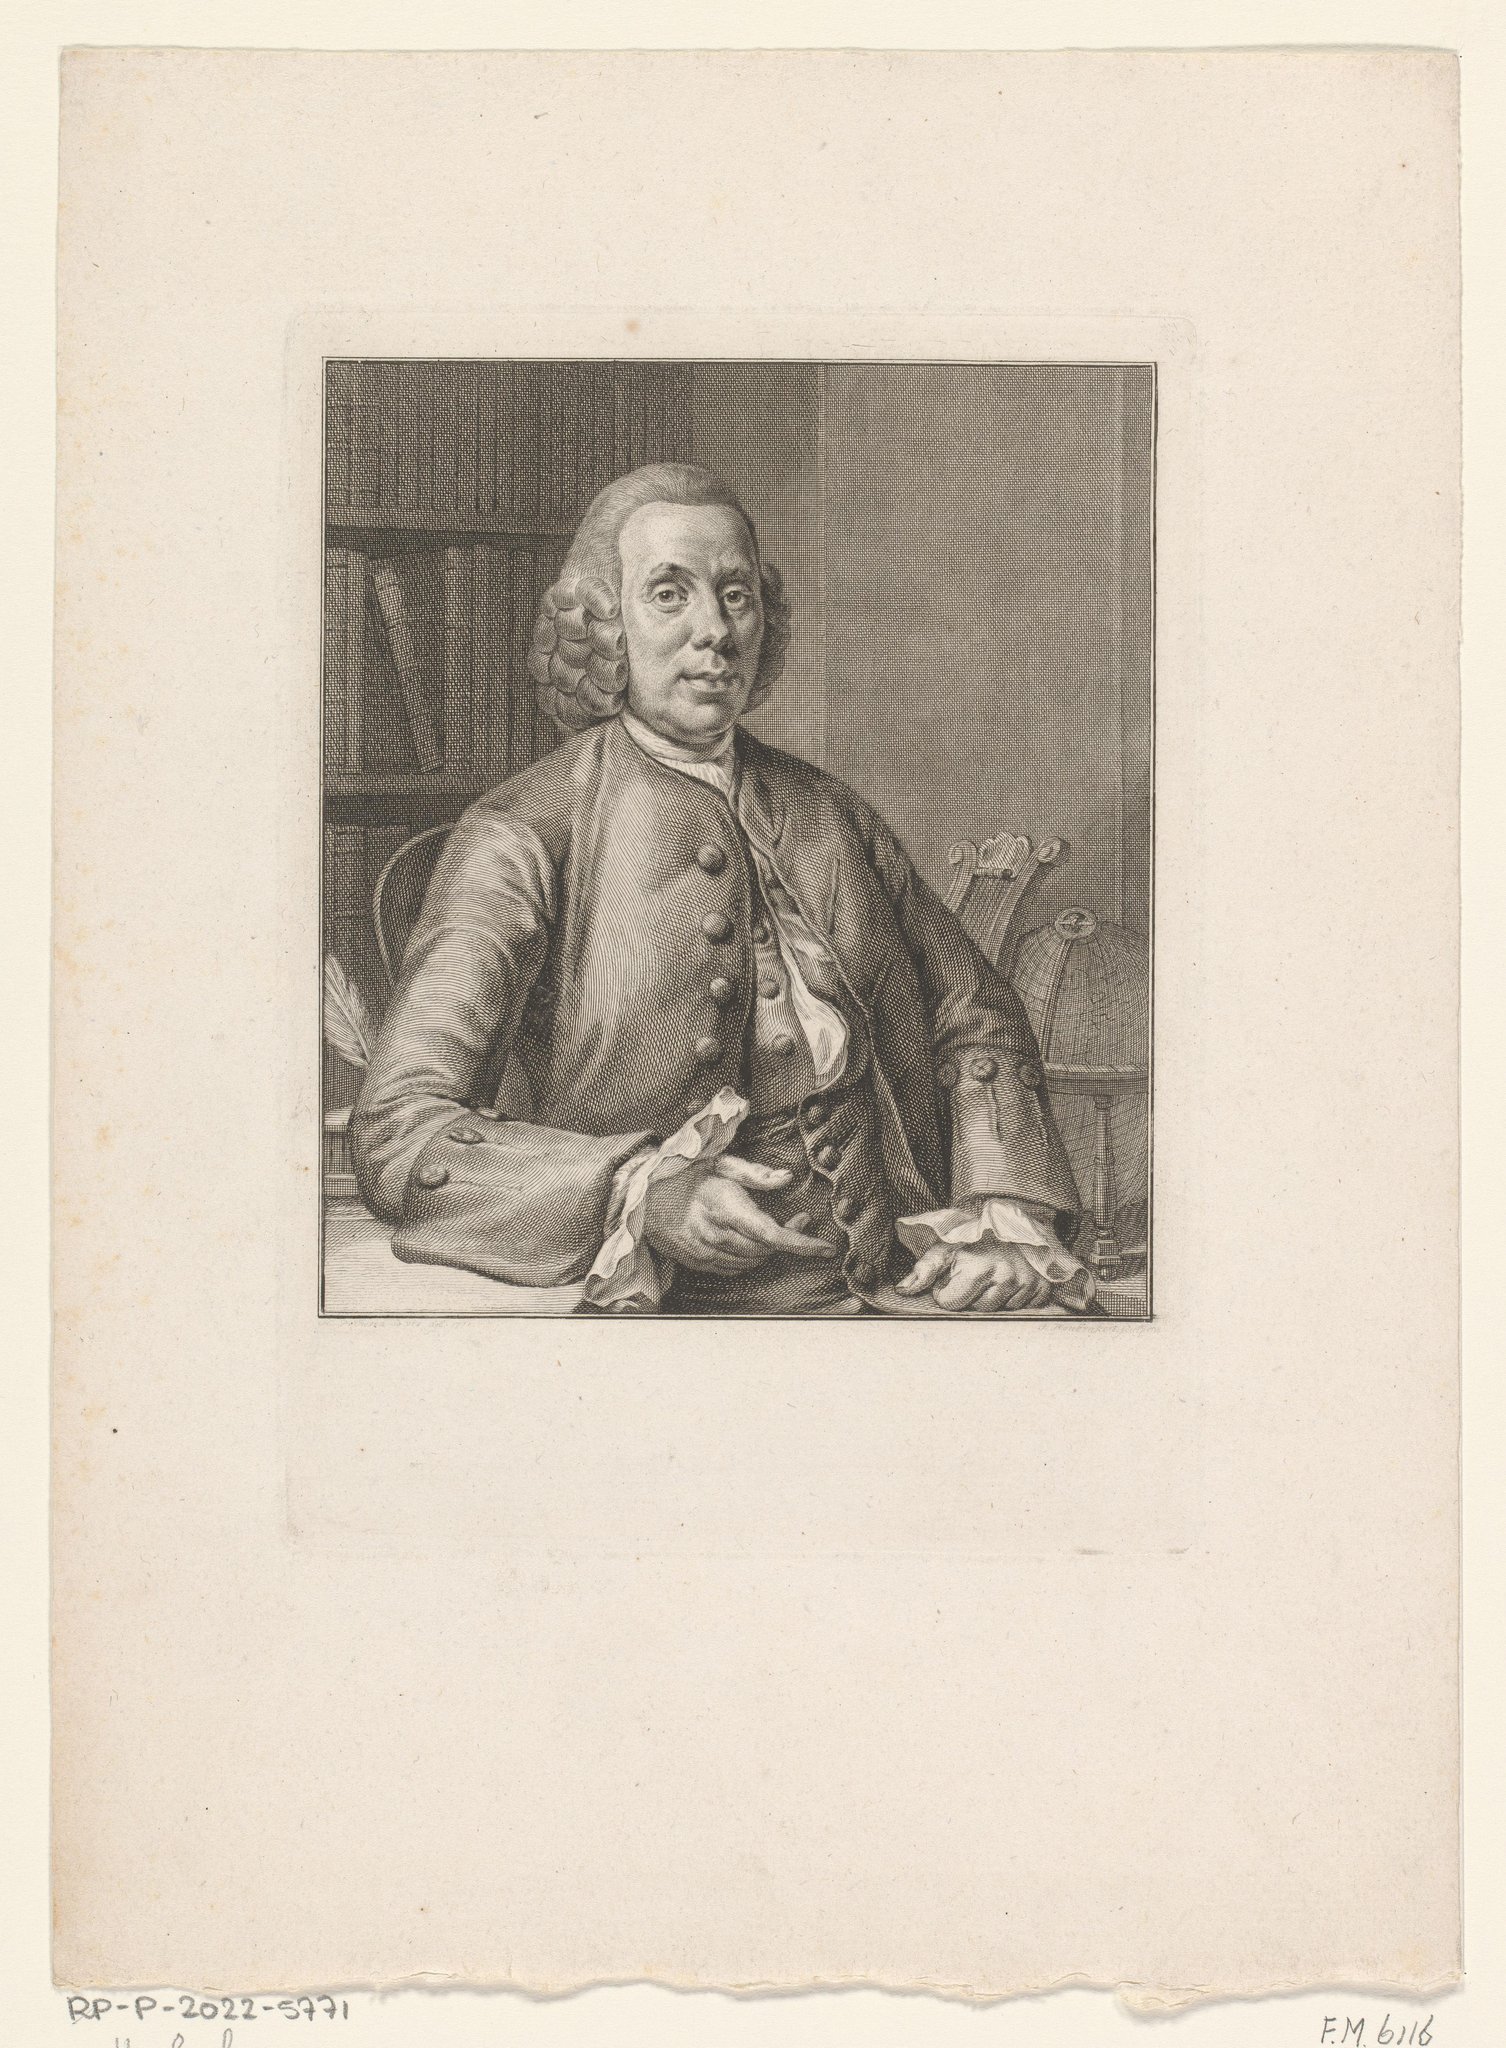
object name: print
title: Portret van Nicolaas Simon van Winter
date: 1771-1773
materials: paper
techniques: engraving, etching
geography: amsterdam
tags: historical persons, portrait of a writer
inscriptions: collector's mark: Lugt 2228